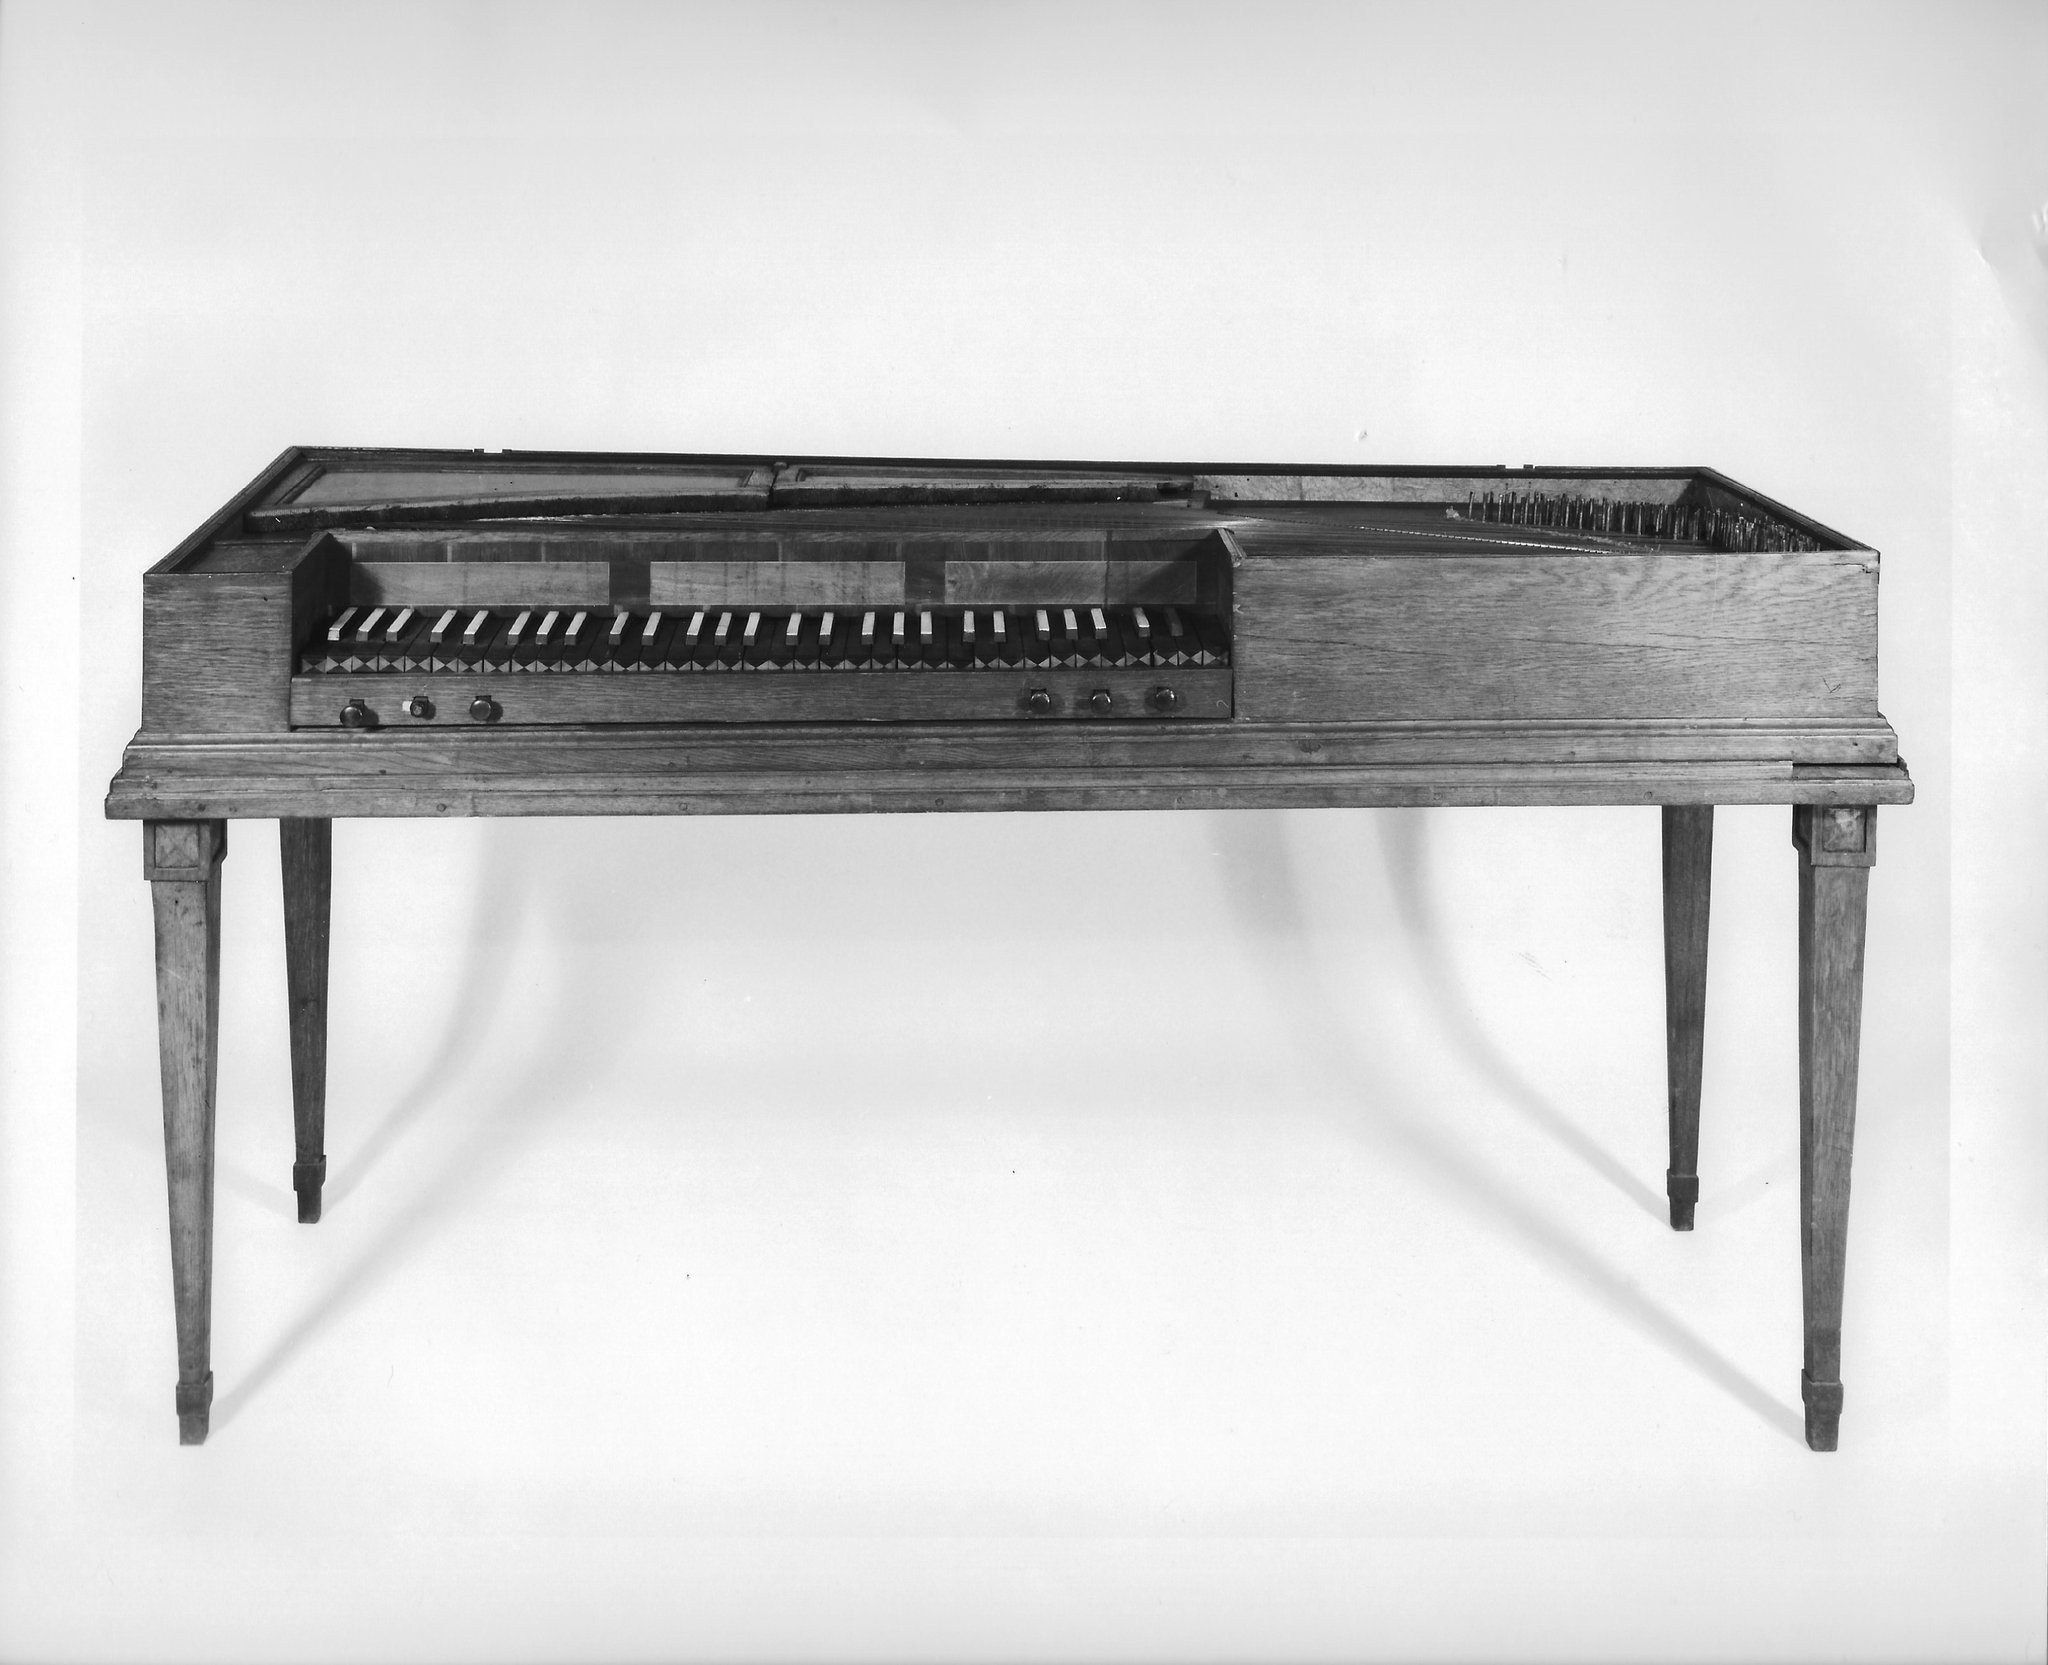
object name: square piano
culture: german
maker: johann christoph jaeckel and christian jaeckel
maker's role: maker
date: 1790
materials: wood, iron, ivory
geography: germany